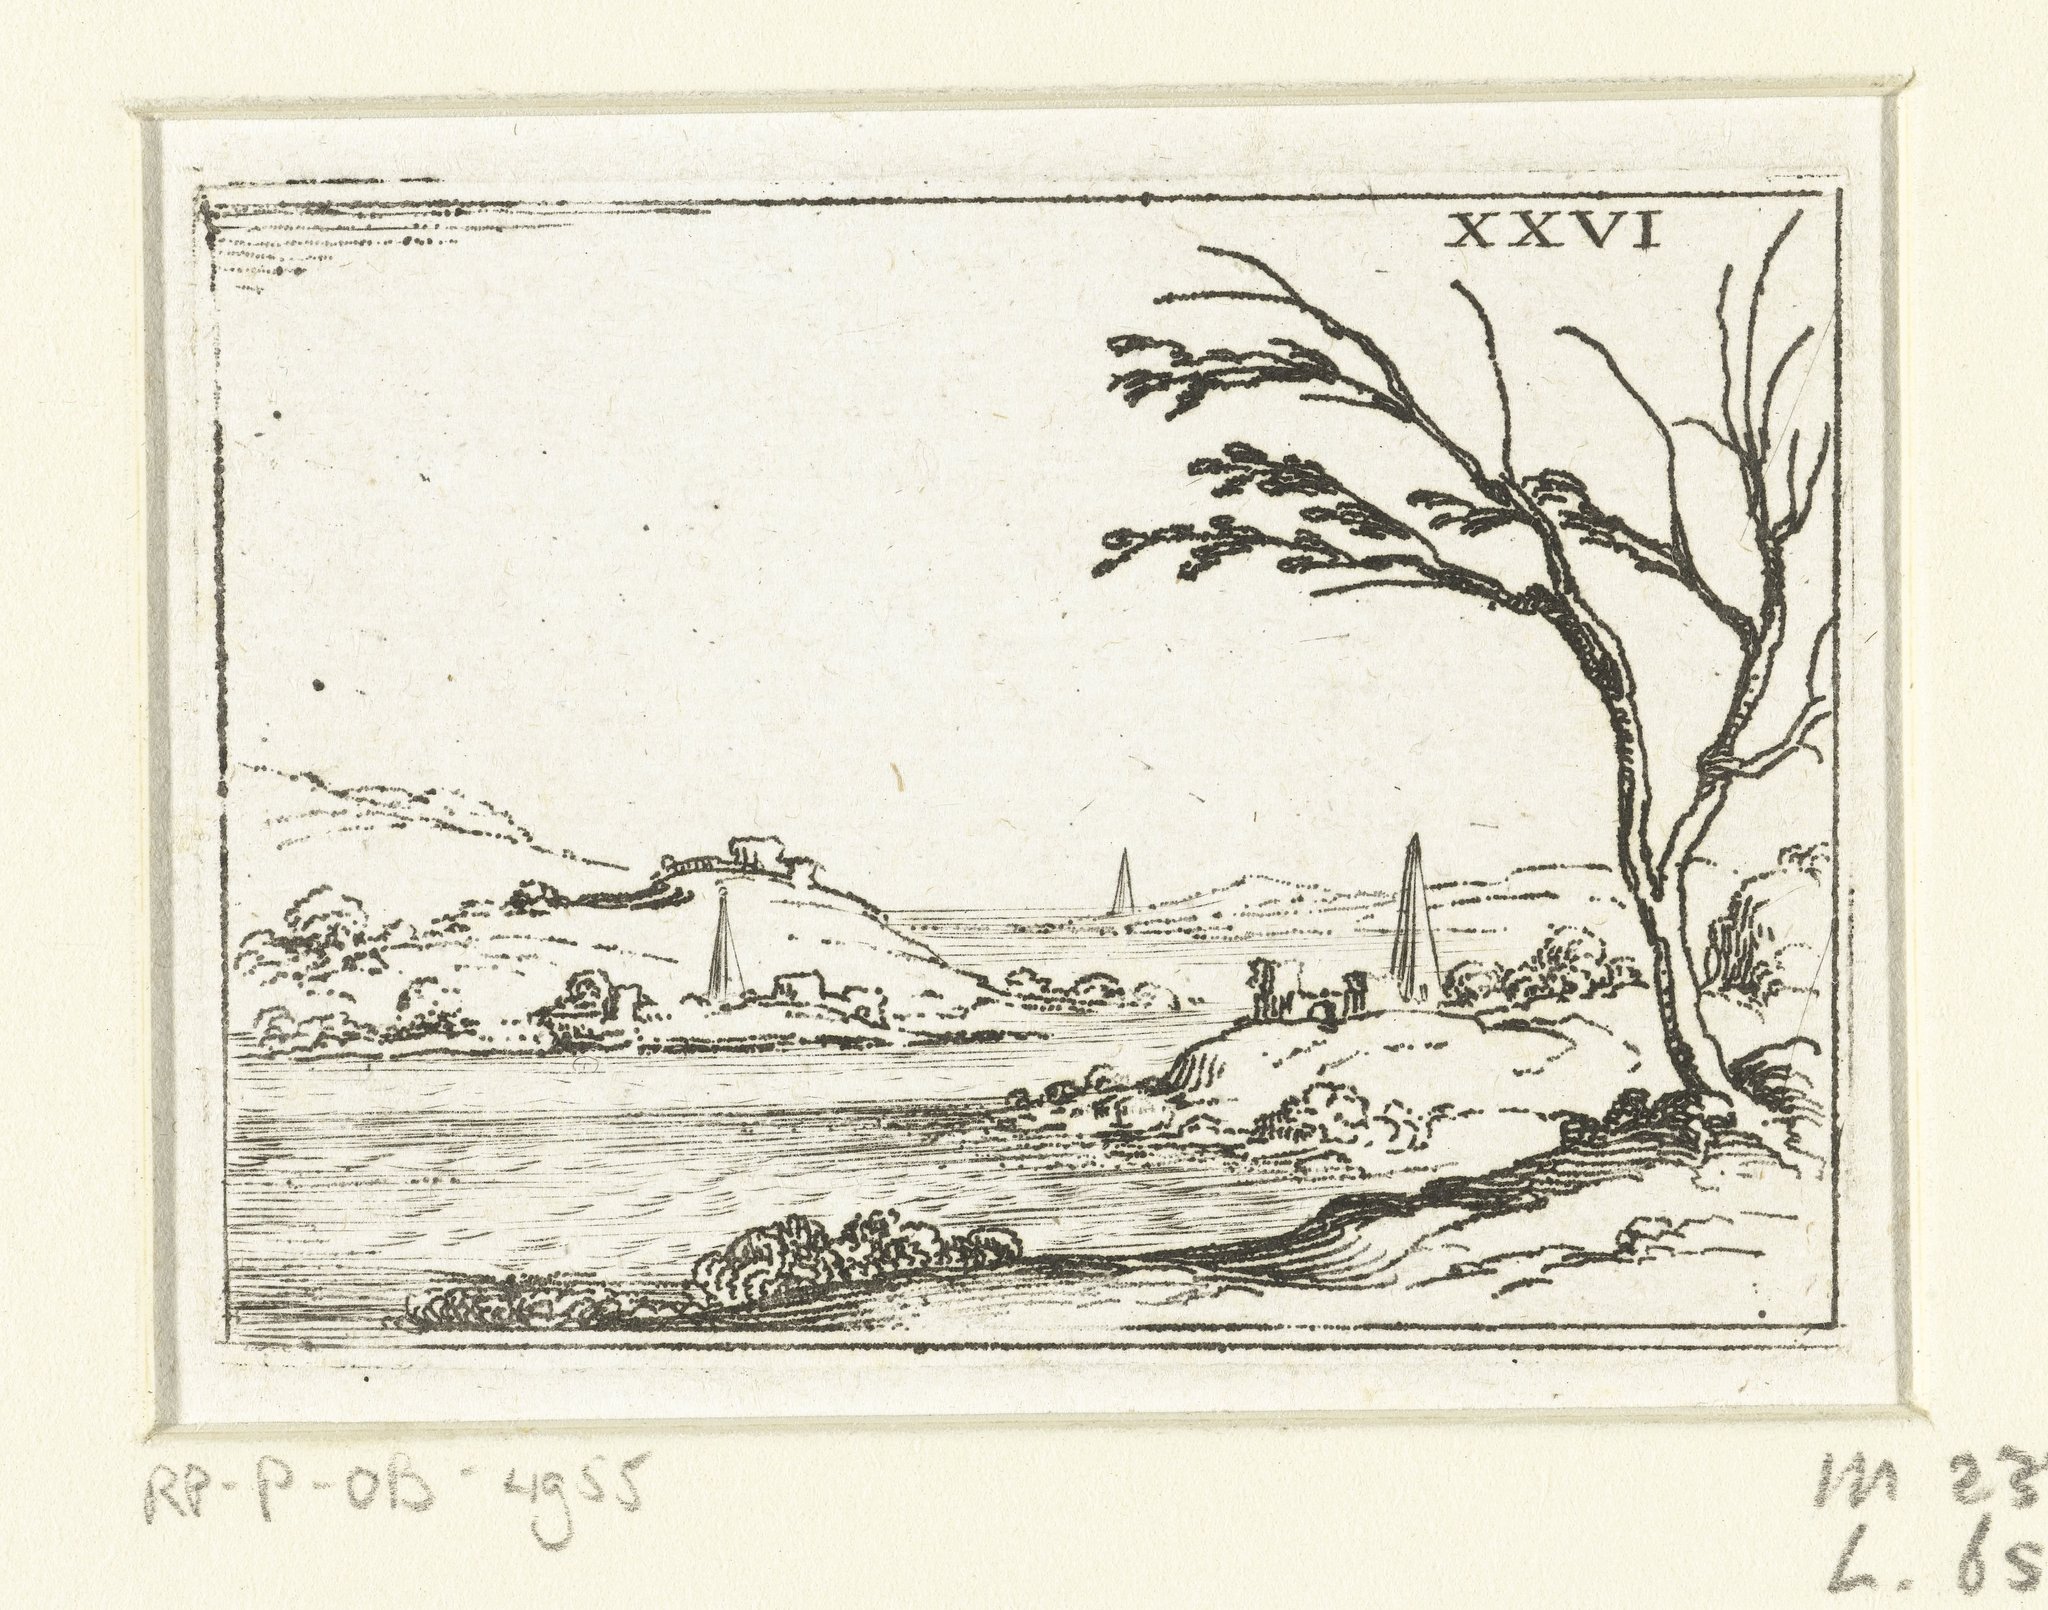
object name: cognizance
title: Leven van Maria in emblemen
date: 1625-1629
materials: paper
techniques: etching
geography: paris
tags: river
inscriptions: collector's mark: Lugt 240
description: Voorstelling van de rivier de Nijl die in Egypte buiten haar oevers treedt en zo het land vruchtbaar maakt. Dit blad is onderdeel van de embleemserie 'Leven van Maria in emblemen'. De eerste staat van deze serie behelst naast een titelpagina en 26 emblemen ook drie bladen met lofzangen op Maria in boekdruk zonder afbeelding.